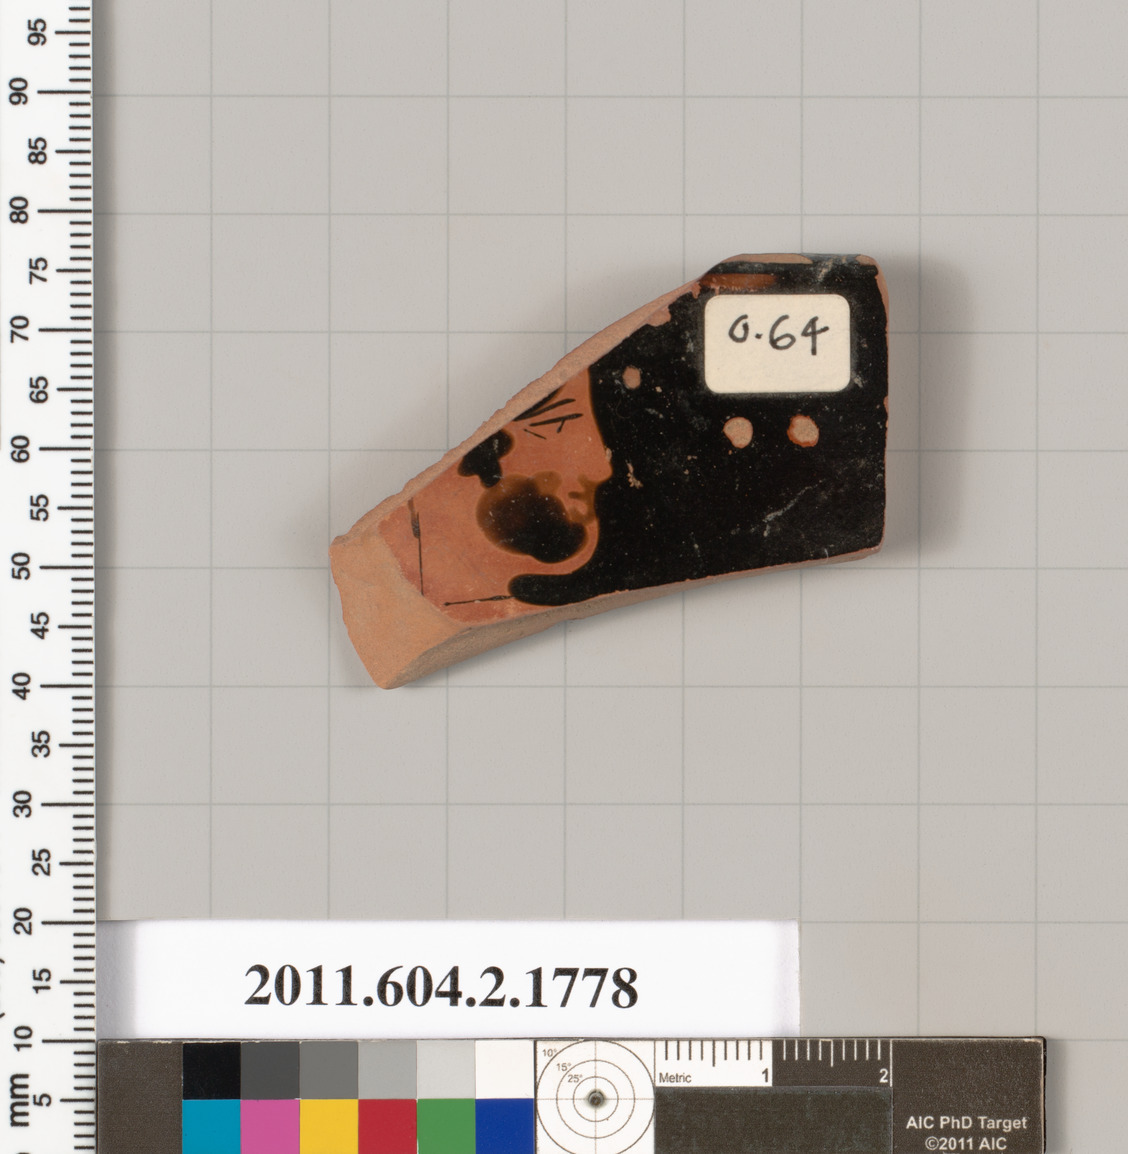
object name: skyphos fragment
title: Terracotta rim fragment of a skyphos (deep drinking cup)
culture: greek, attic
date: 434-368 BCE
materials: terracotta